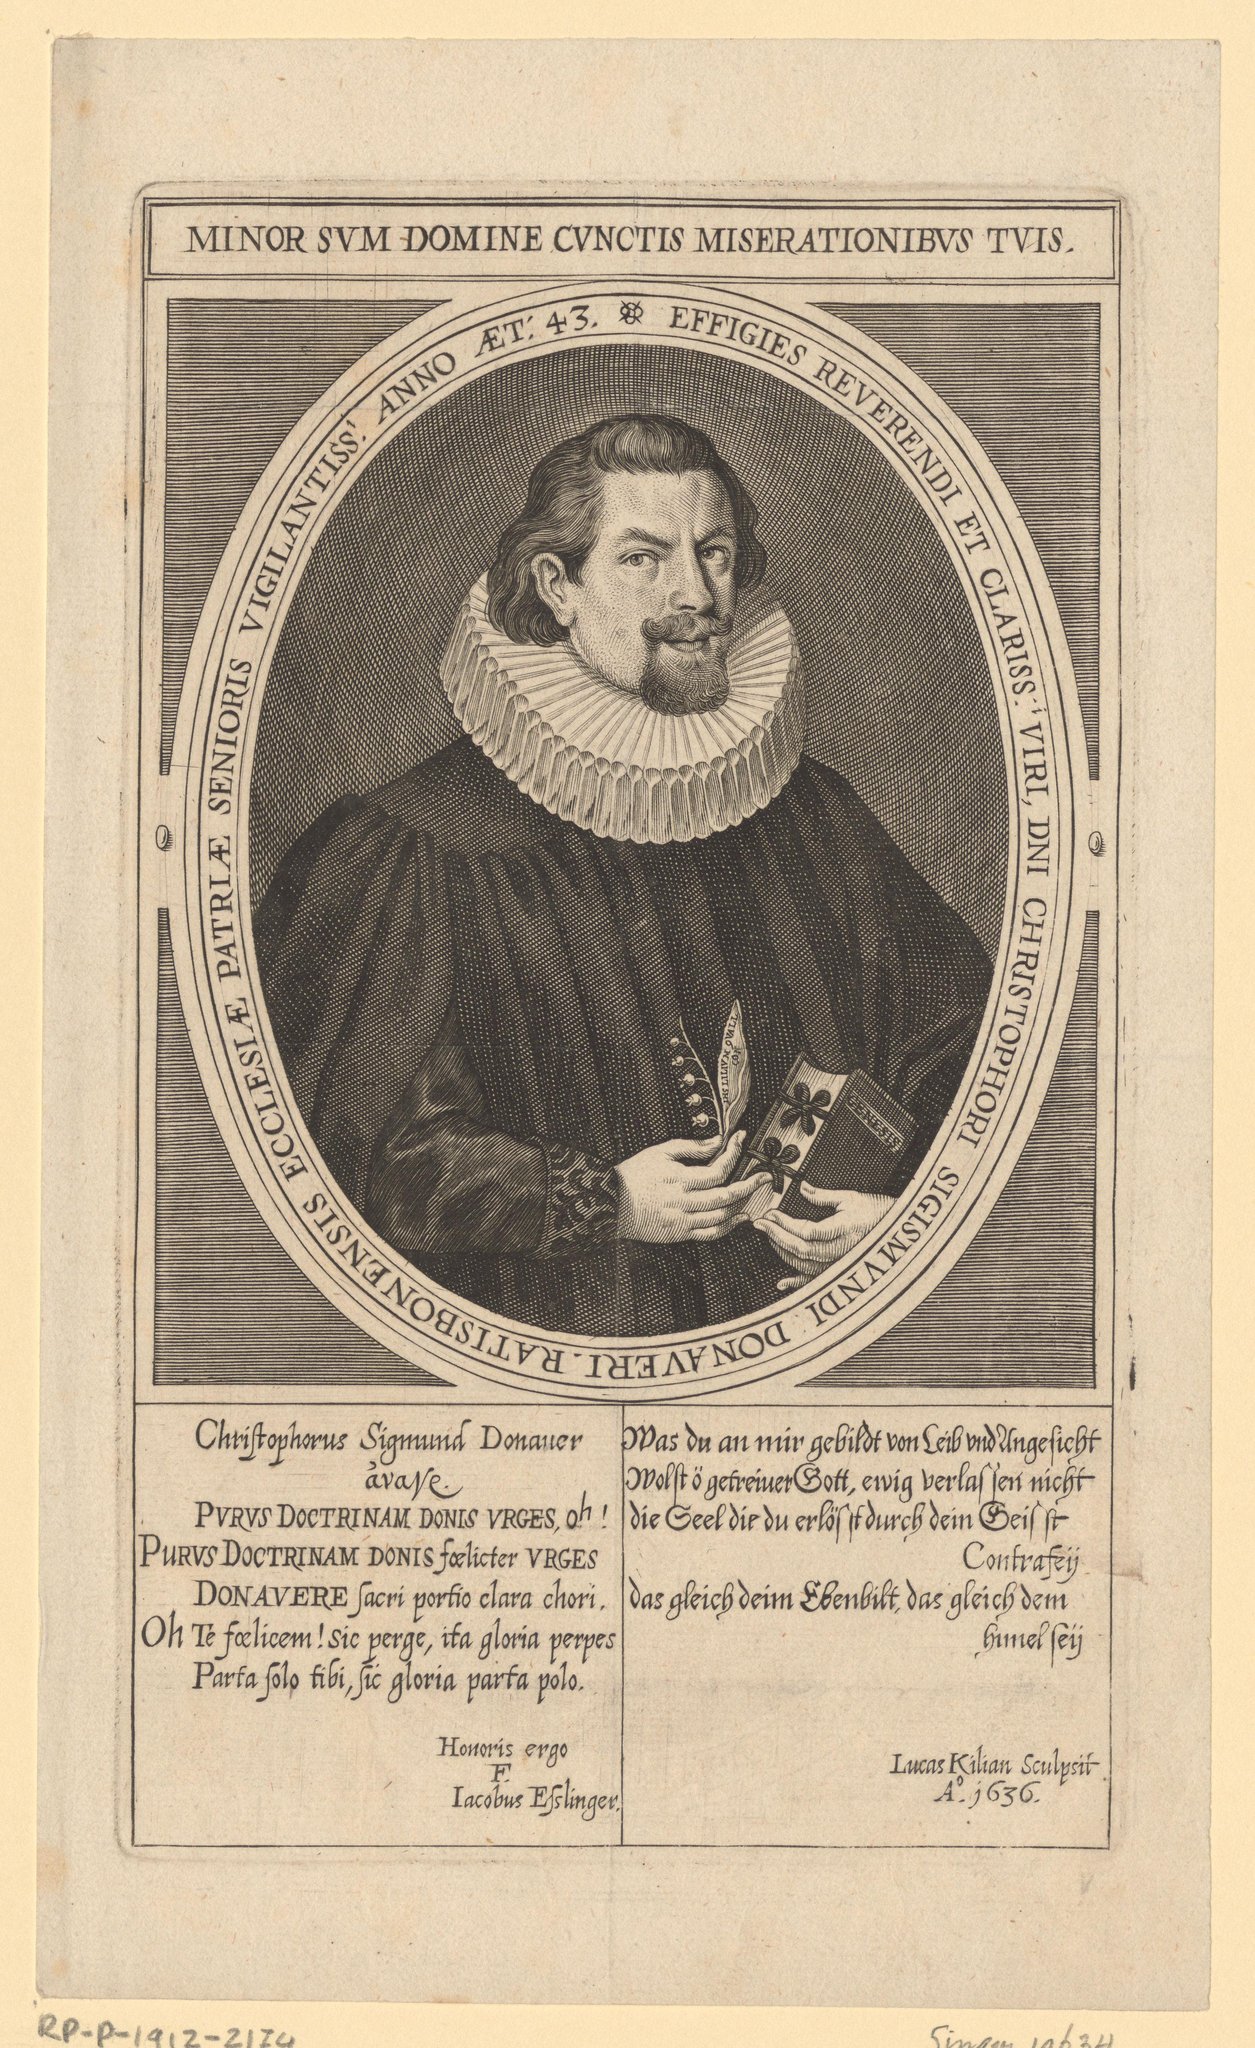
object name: print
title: Portret van Christoph Sigismund Donauer op 43-jarige leeftijd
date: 1636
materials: paper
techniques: engraving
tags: christoph sigmund i donauer, historical persons, organization, functionaries and dignitaries in churches and in related institutions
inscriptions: collector's mark: Lugt 2228